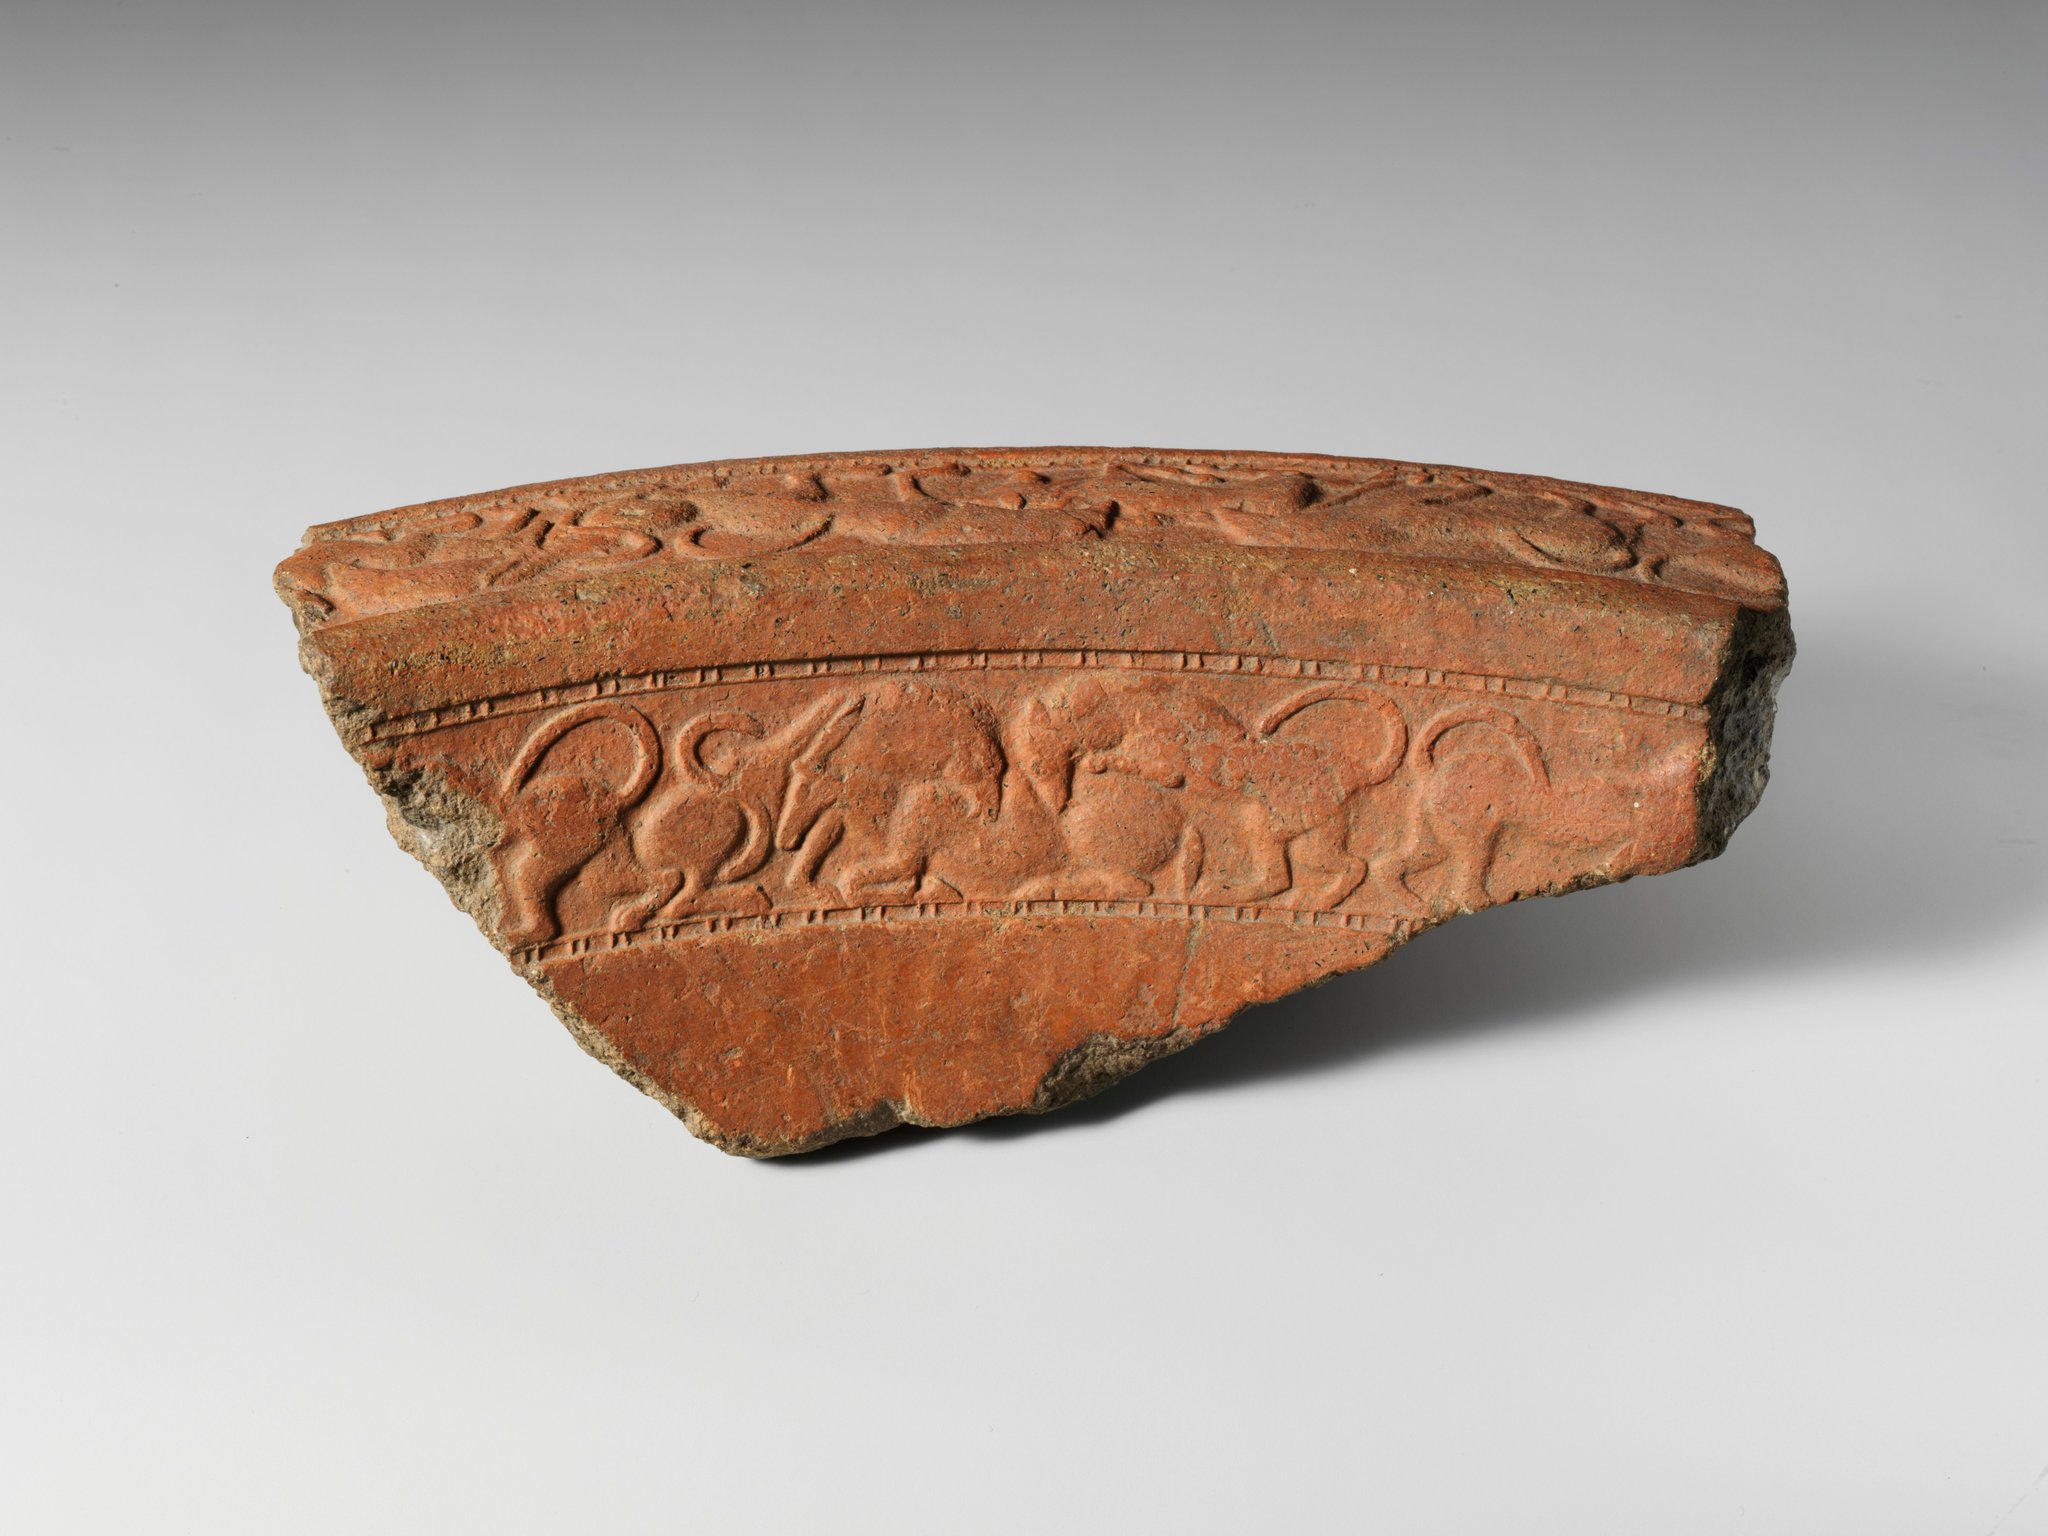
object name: brazier fragment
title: Terracotta brazier fragment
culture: etruscan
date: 540-530 BCE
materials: terracotta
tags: bulls,deer,lions